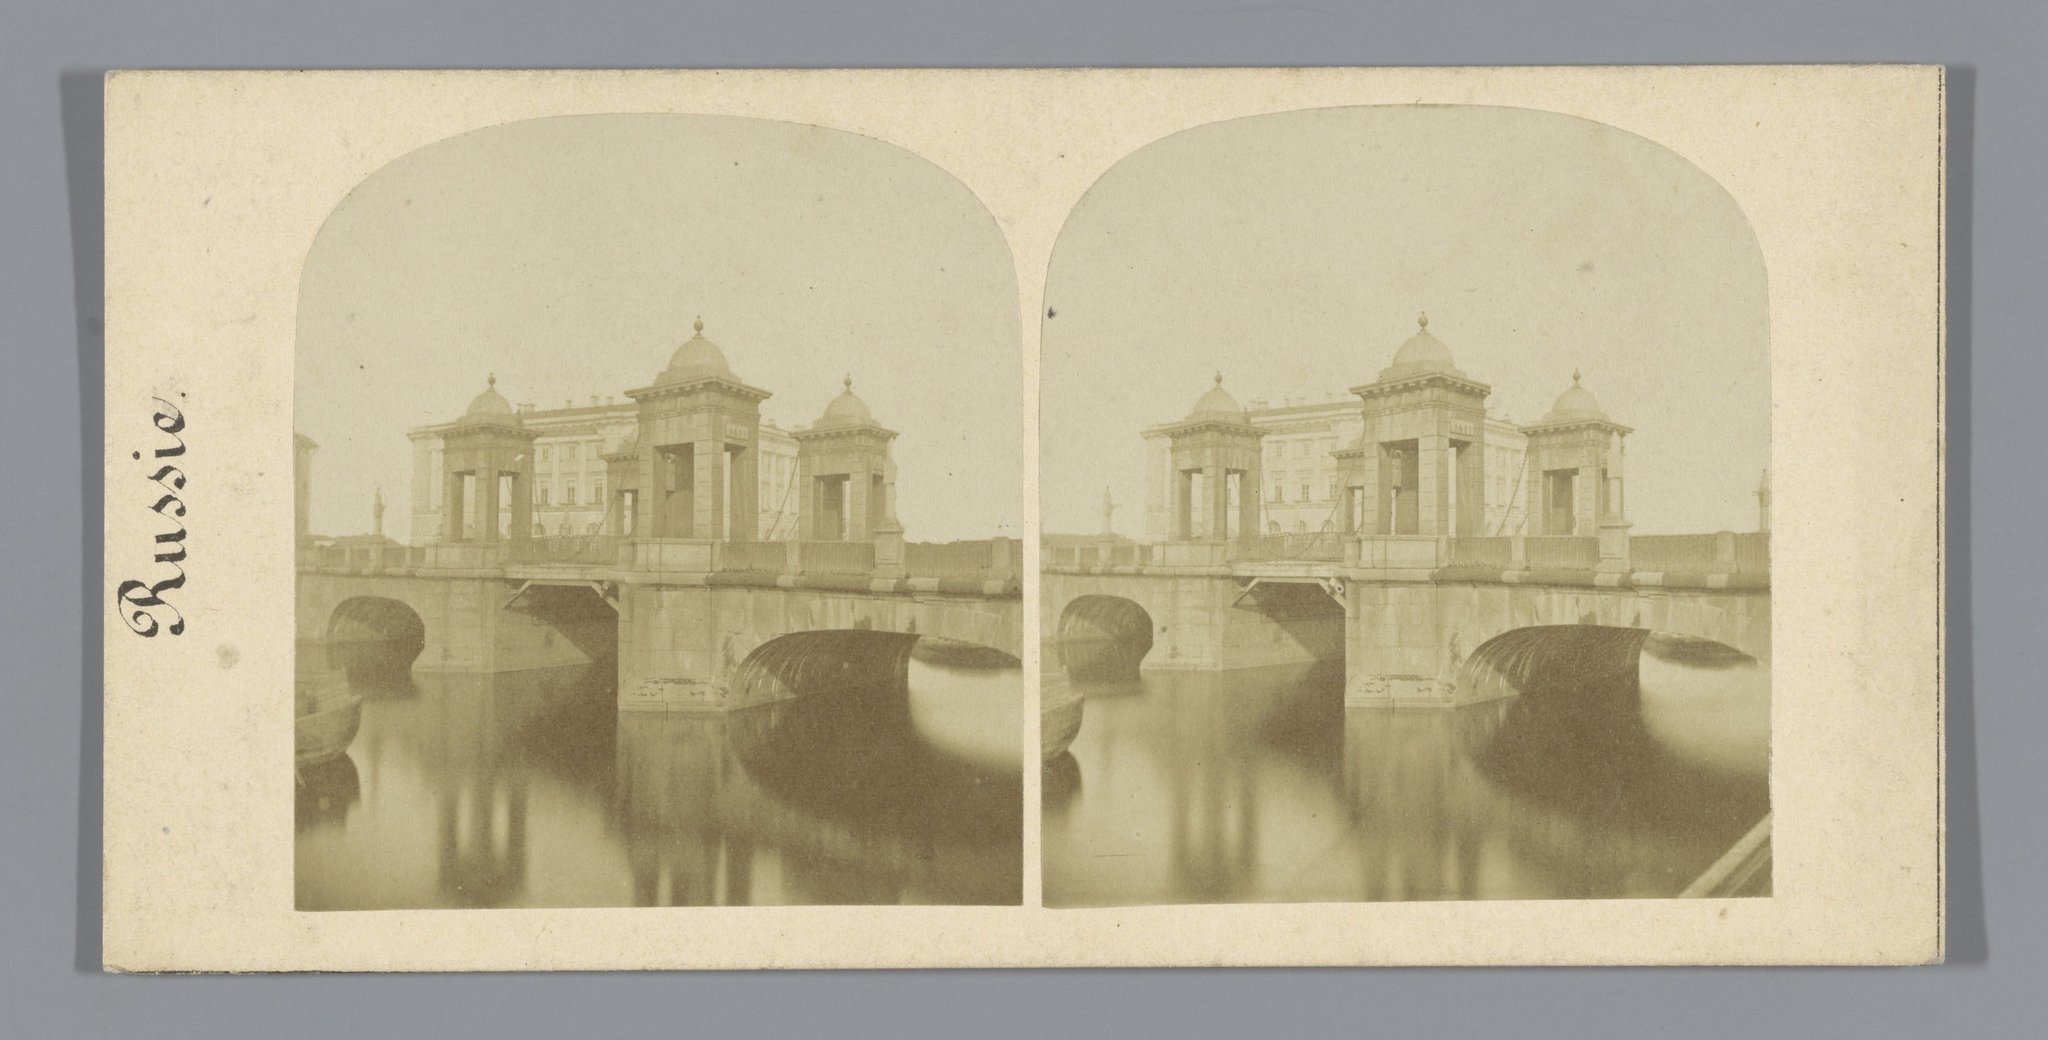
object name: stereograph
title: Gezicht op de Lomonosovbrug in Sint-Petersburg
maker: Anonymous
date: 1850-1880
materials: cardboard, photographic support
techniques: albumen print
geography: sint-petersburg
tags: bridge in city across river, canal, etc.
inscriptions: inscription: ‘No 20 Pont de Troitsk St. Petersbourg’, inscription: ‘Russie’